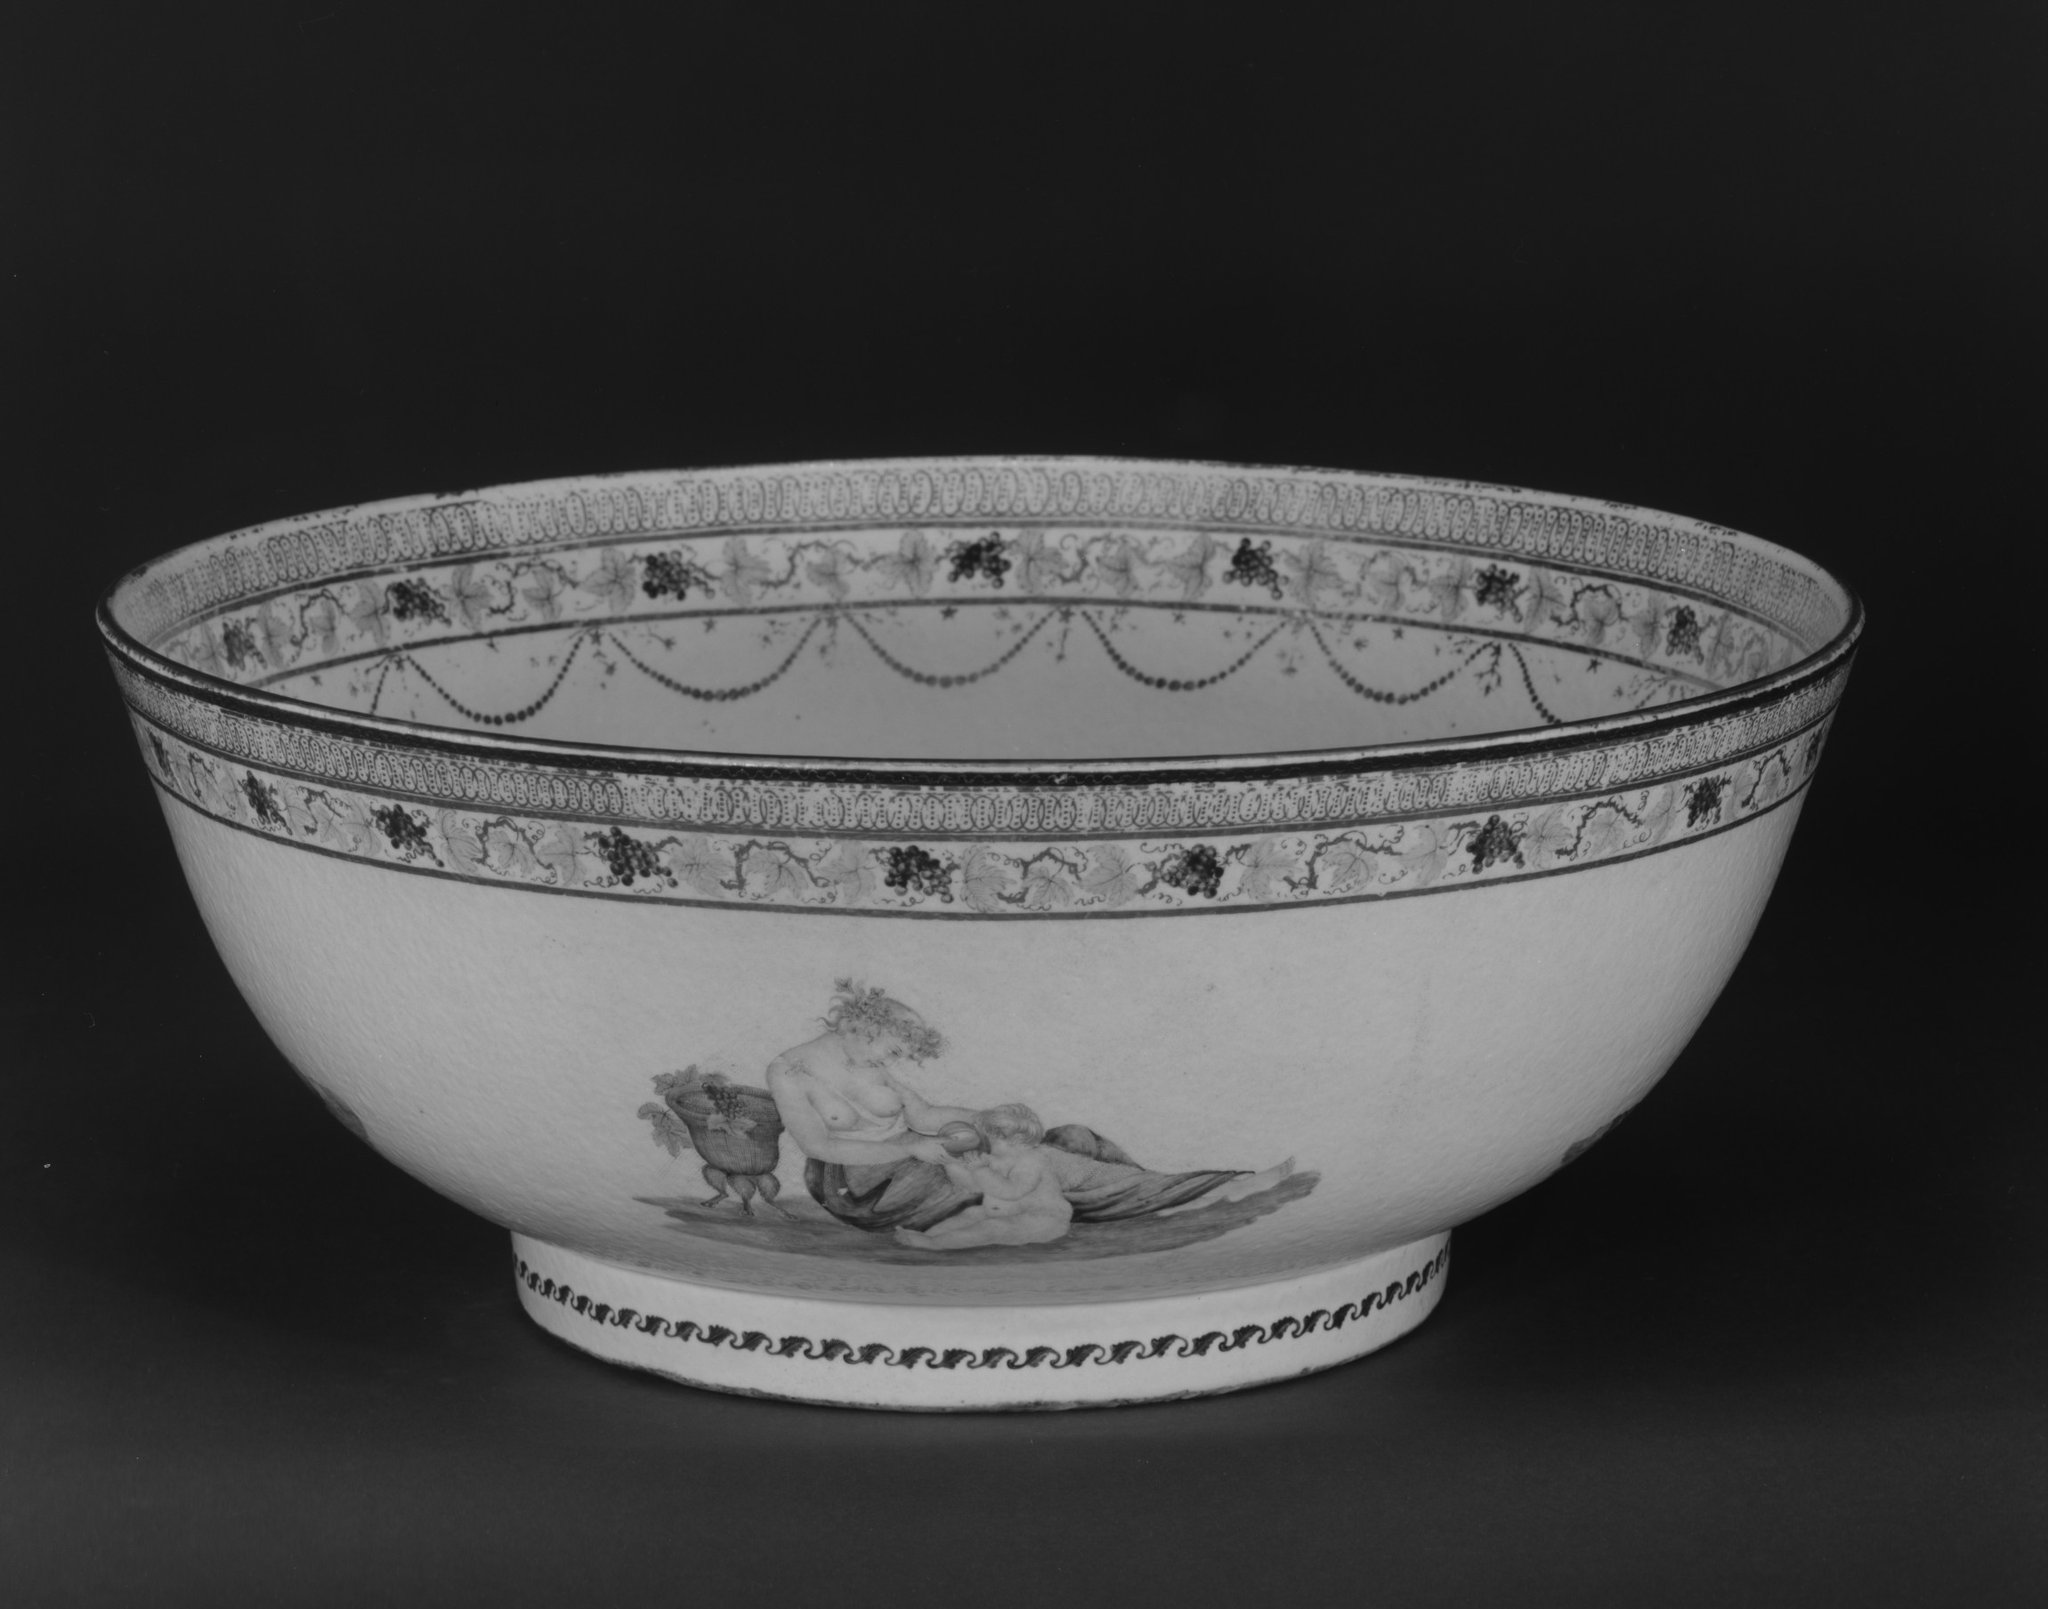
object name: punch bowl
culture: chinese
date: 1800-1805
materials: porcelain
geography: china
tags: grapes,infants,female nudes,drinking